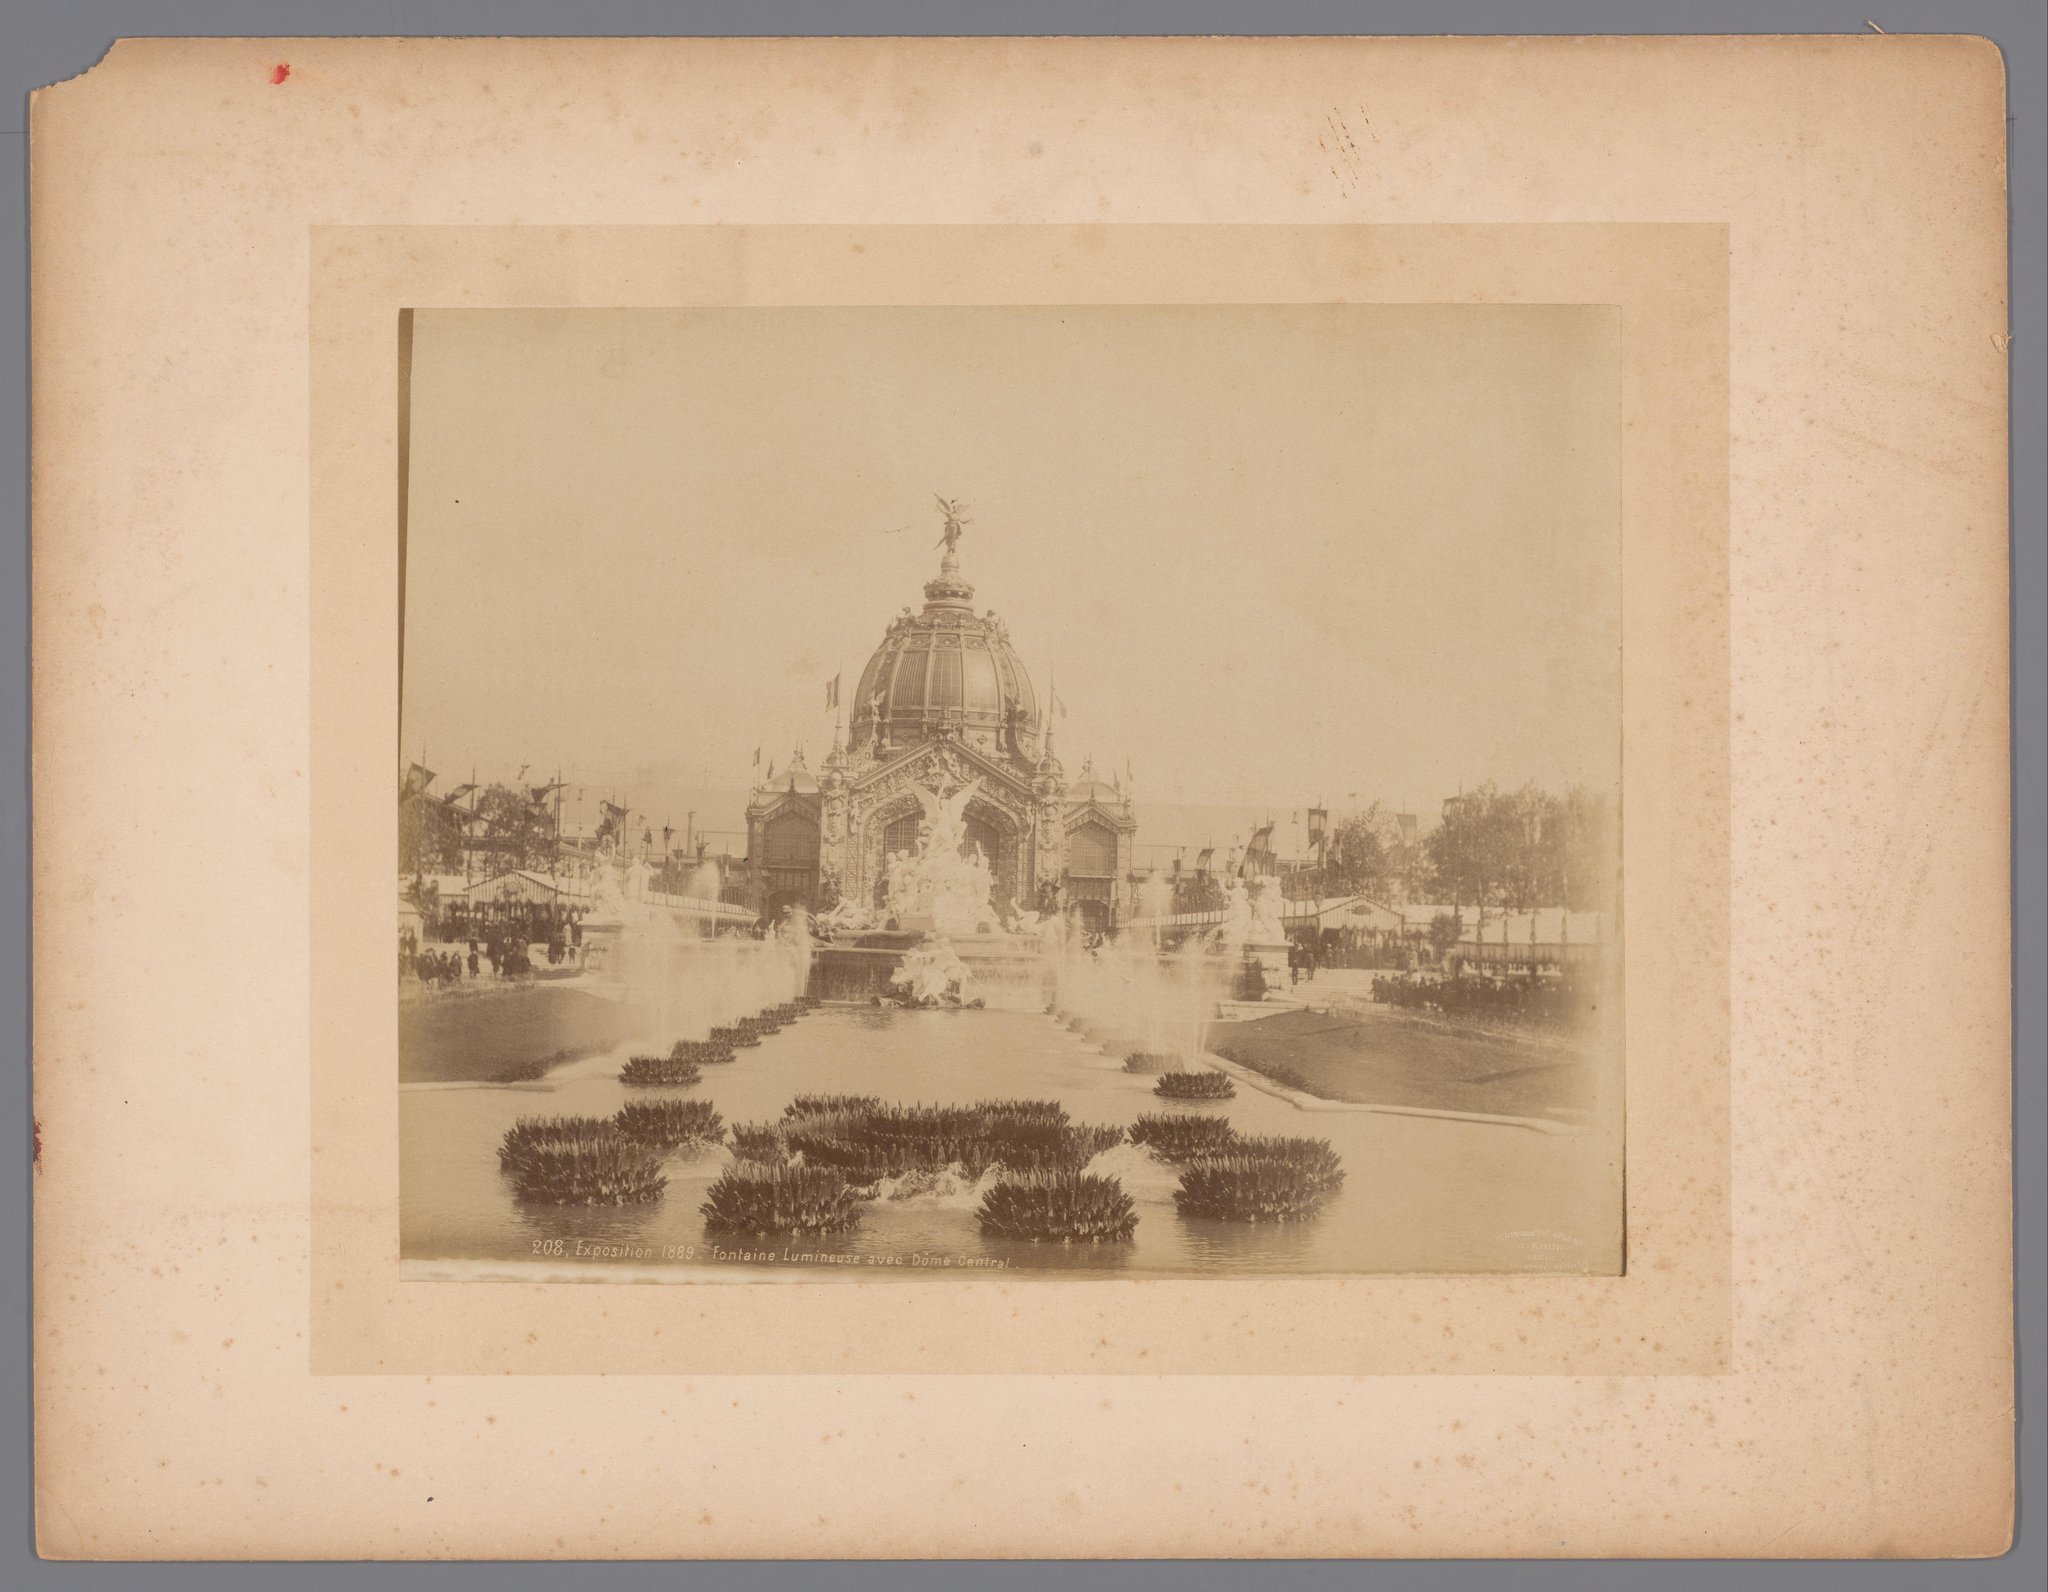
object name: photograph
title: Wereldtentoonstelling 1889 ('Exposition 1889 - fontaine Lumineuse avec Dôme Central.'), Parijs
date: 1889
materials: cardboard, paper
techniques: albumen print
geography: paris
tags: paris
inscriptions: inscription: ‘208, Exposition 1889 - fontaine Lumineuse avec Dôme Central’, check stamp: ‘Photographic Company//J. Kühn//Paris//220 170174 Rue de Rivoli’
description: Wereldtentoonstelling 1889 ('Exposition 1889 - fontaine Lumineuse avec Dôme Central.'), Parijs, Frankrijk.